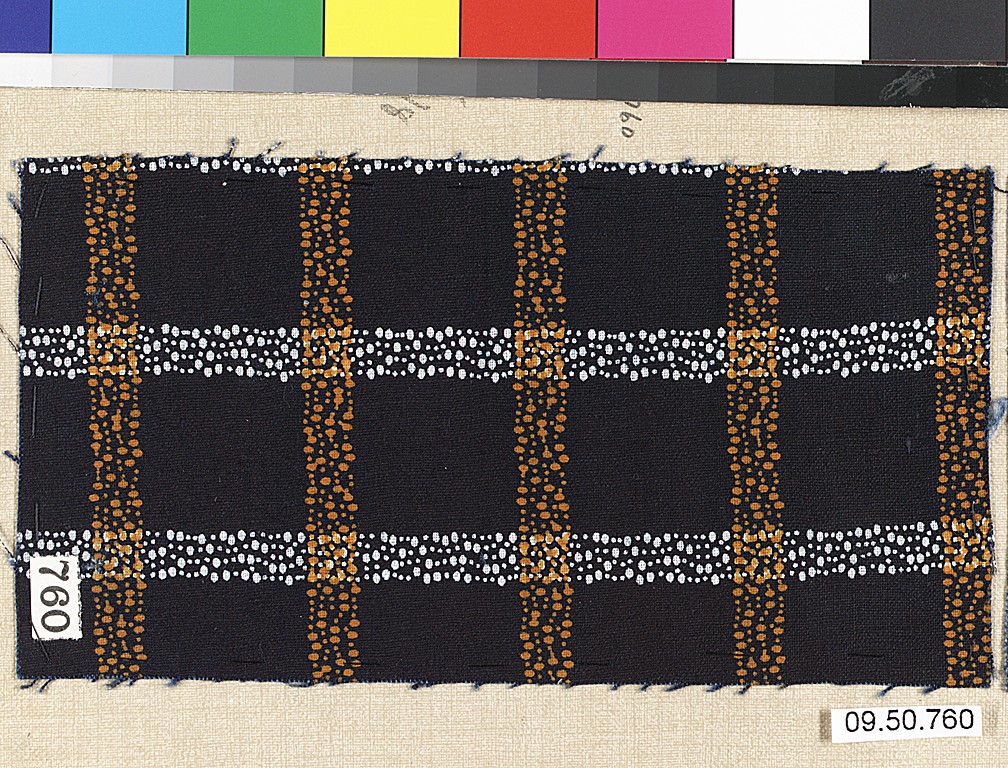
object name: piece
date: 1801-1900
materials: cotton